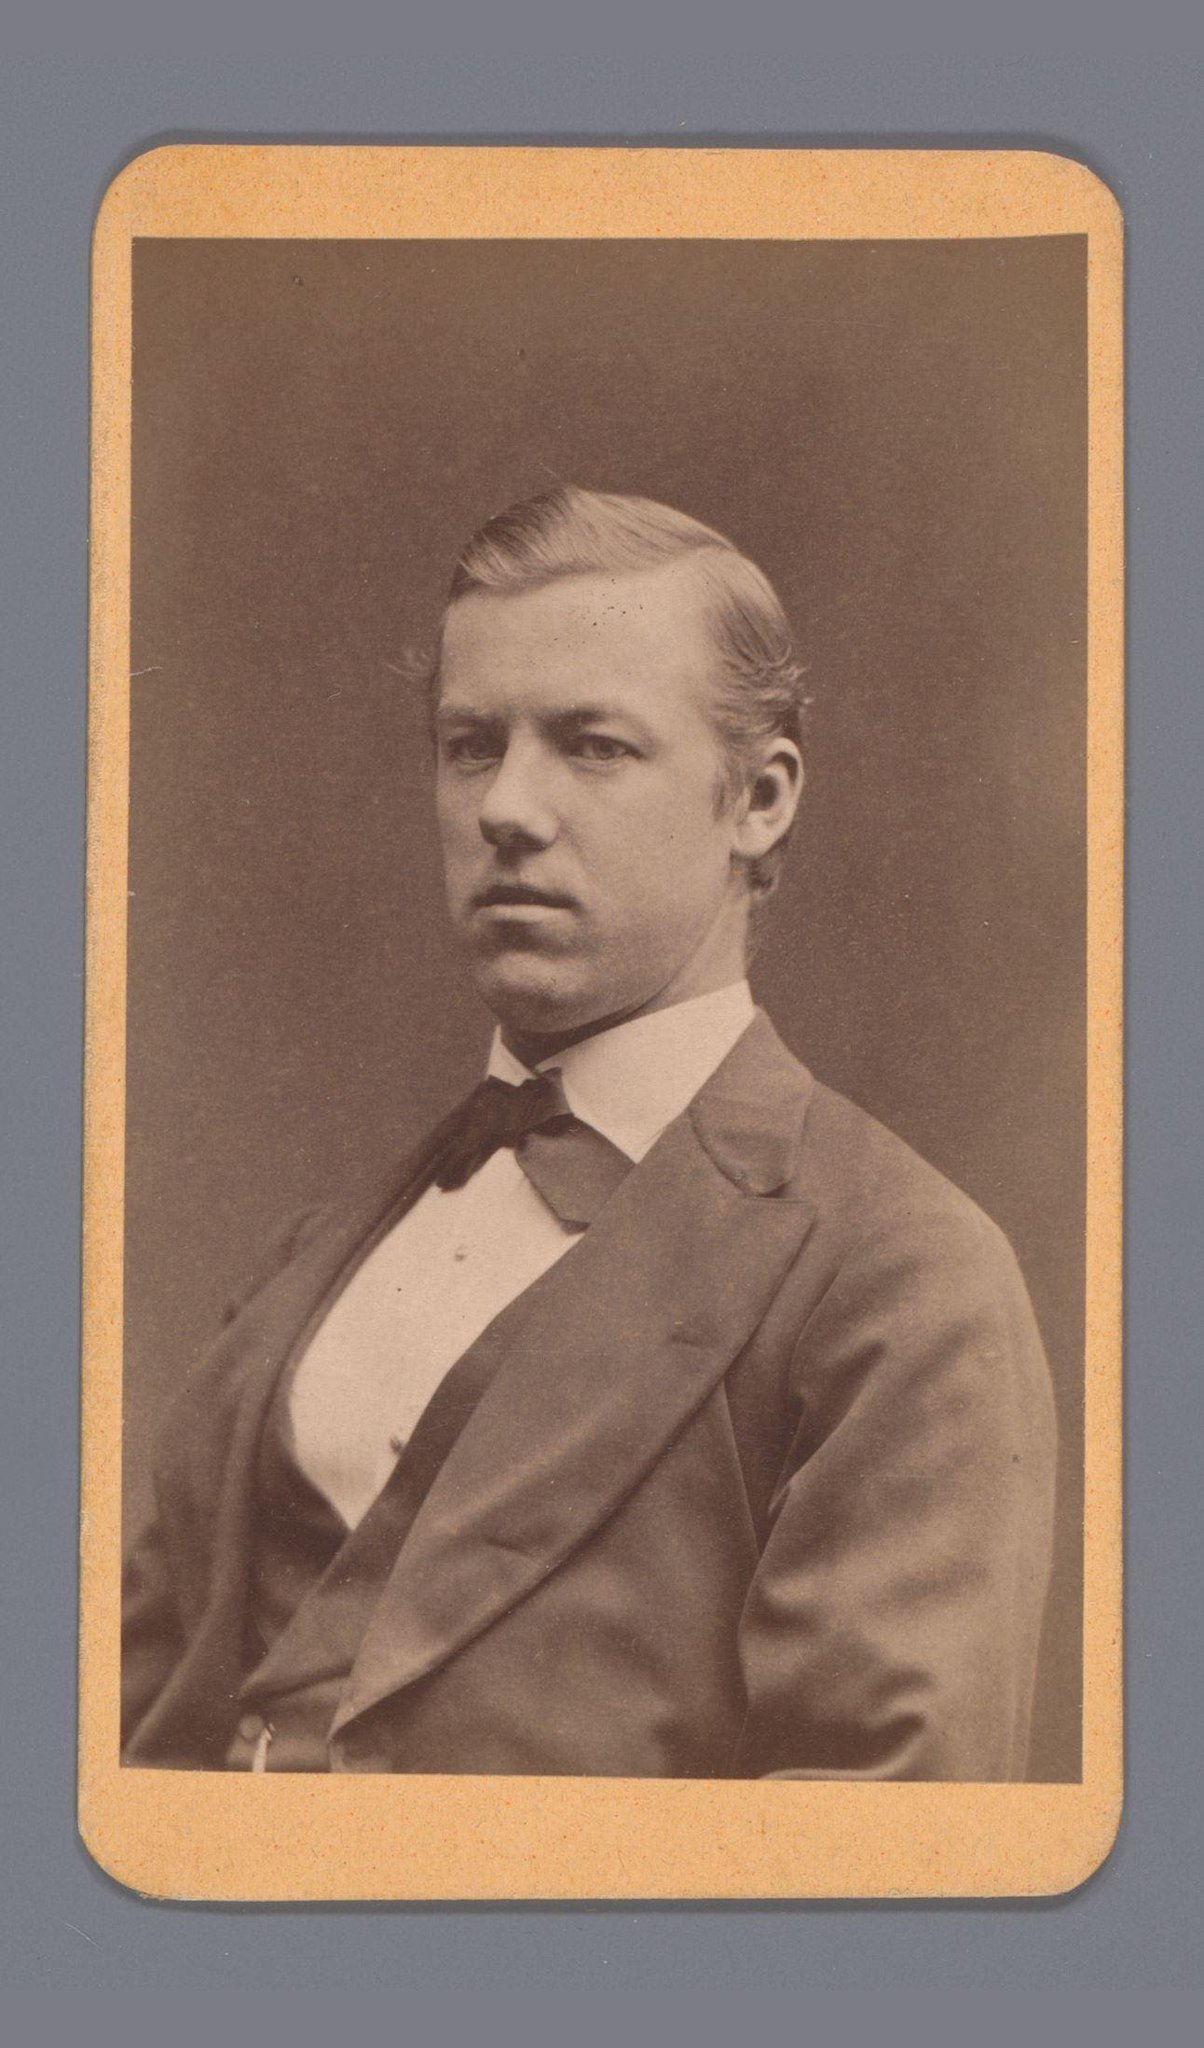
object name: carte de visite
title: Portret van een onbekende man, aangeduid als J. G. Spangenberg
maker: bernhard hakelier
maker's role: fotograaf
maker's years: 1848-1910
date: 1873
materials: cardboard, paper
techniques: albumen print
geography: orebro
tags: historical persons, youth, adolescent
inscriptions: inscription: ‘BERHNARD HAKELIER/ Fotografisk Atelier/ ÖREBRO./ 21, Köpmangatan 21./ Större antal af samma sort kan erhållas, om Requi-/ sition insändes till Ateliern./ A larger number of the same sort can be had on/ application to Mr Hakelier 21 Mechant street, Örebro./ On peut en avoir plus de la même sorte S'adresser/ à l'etablissement rue Marchand 21 Örebro.’, inscription: ‘J. G. Spangenberg/ 27/5 1873.’